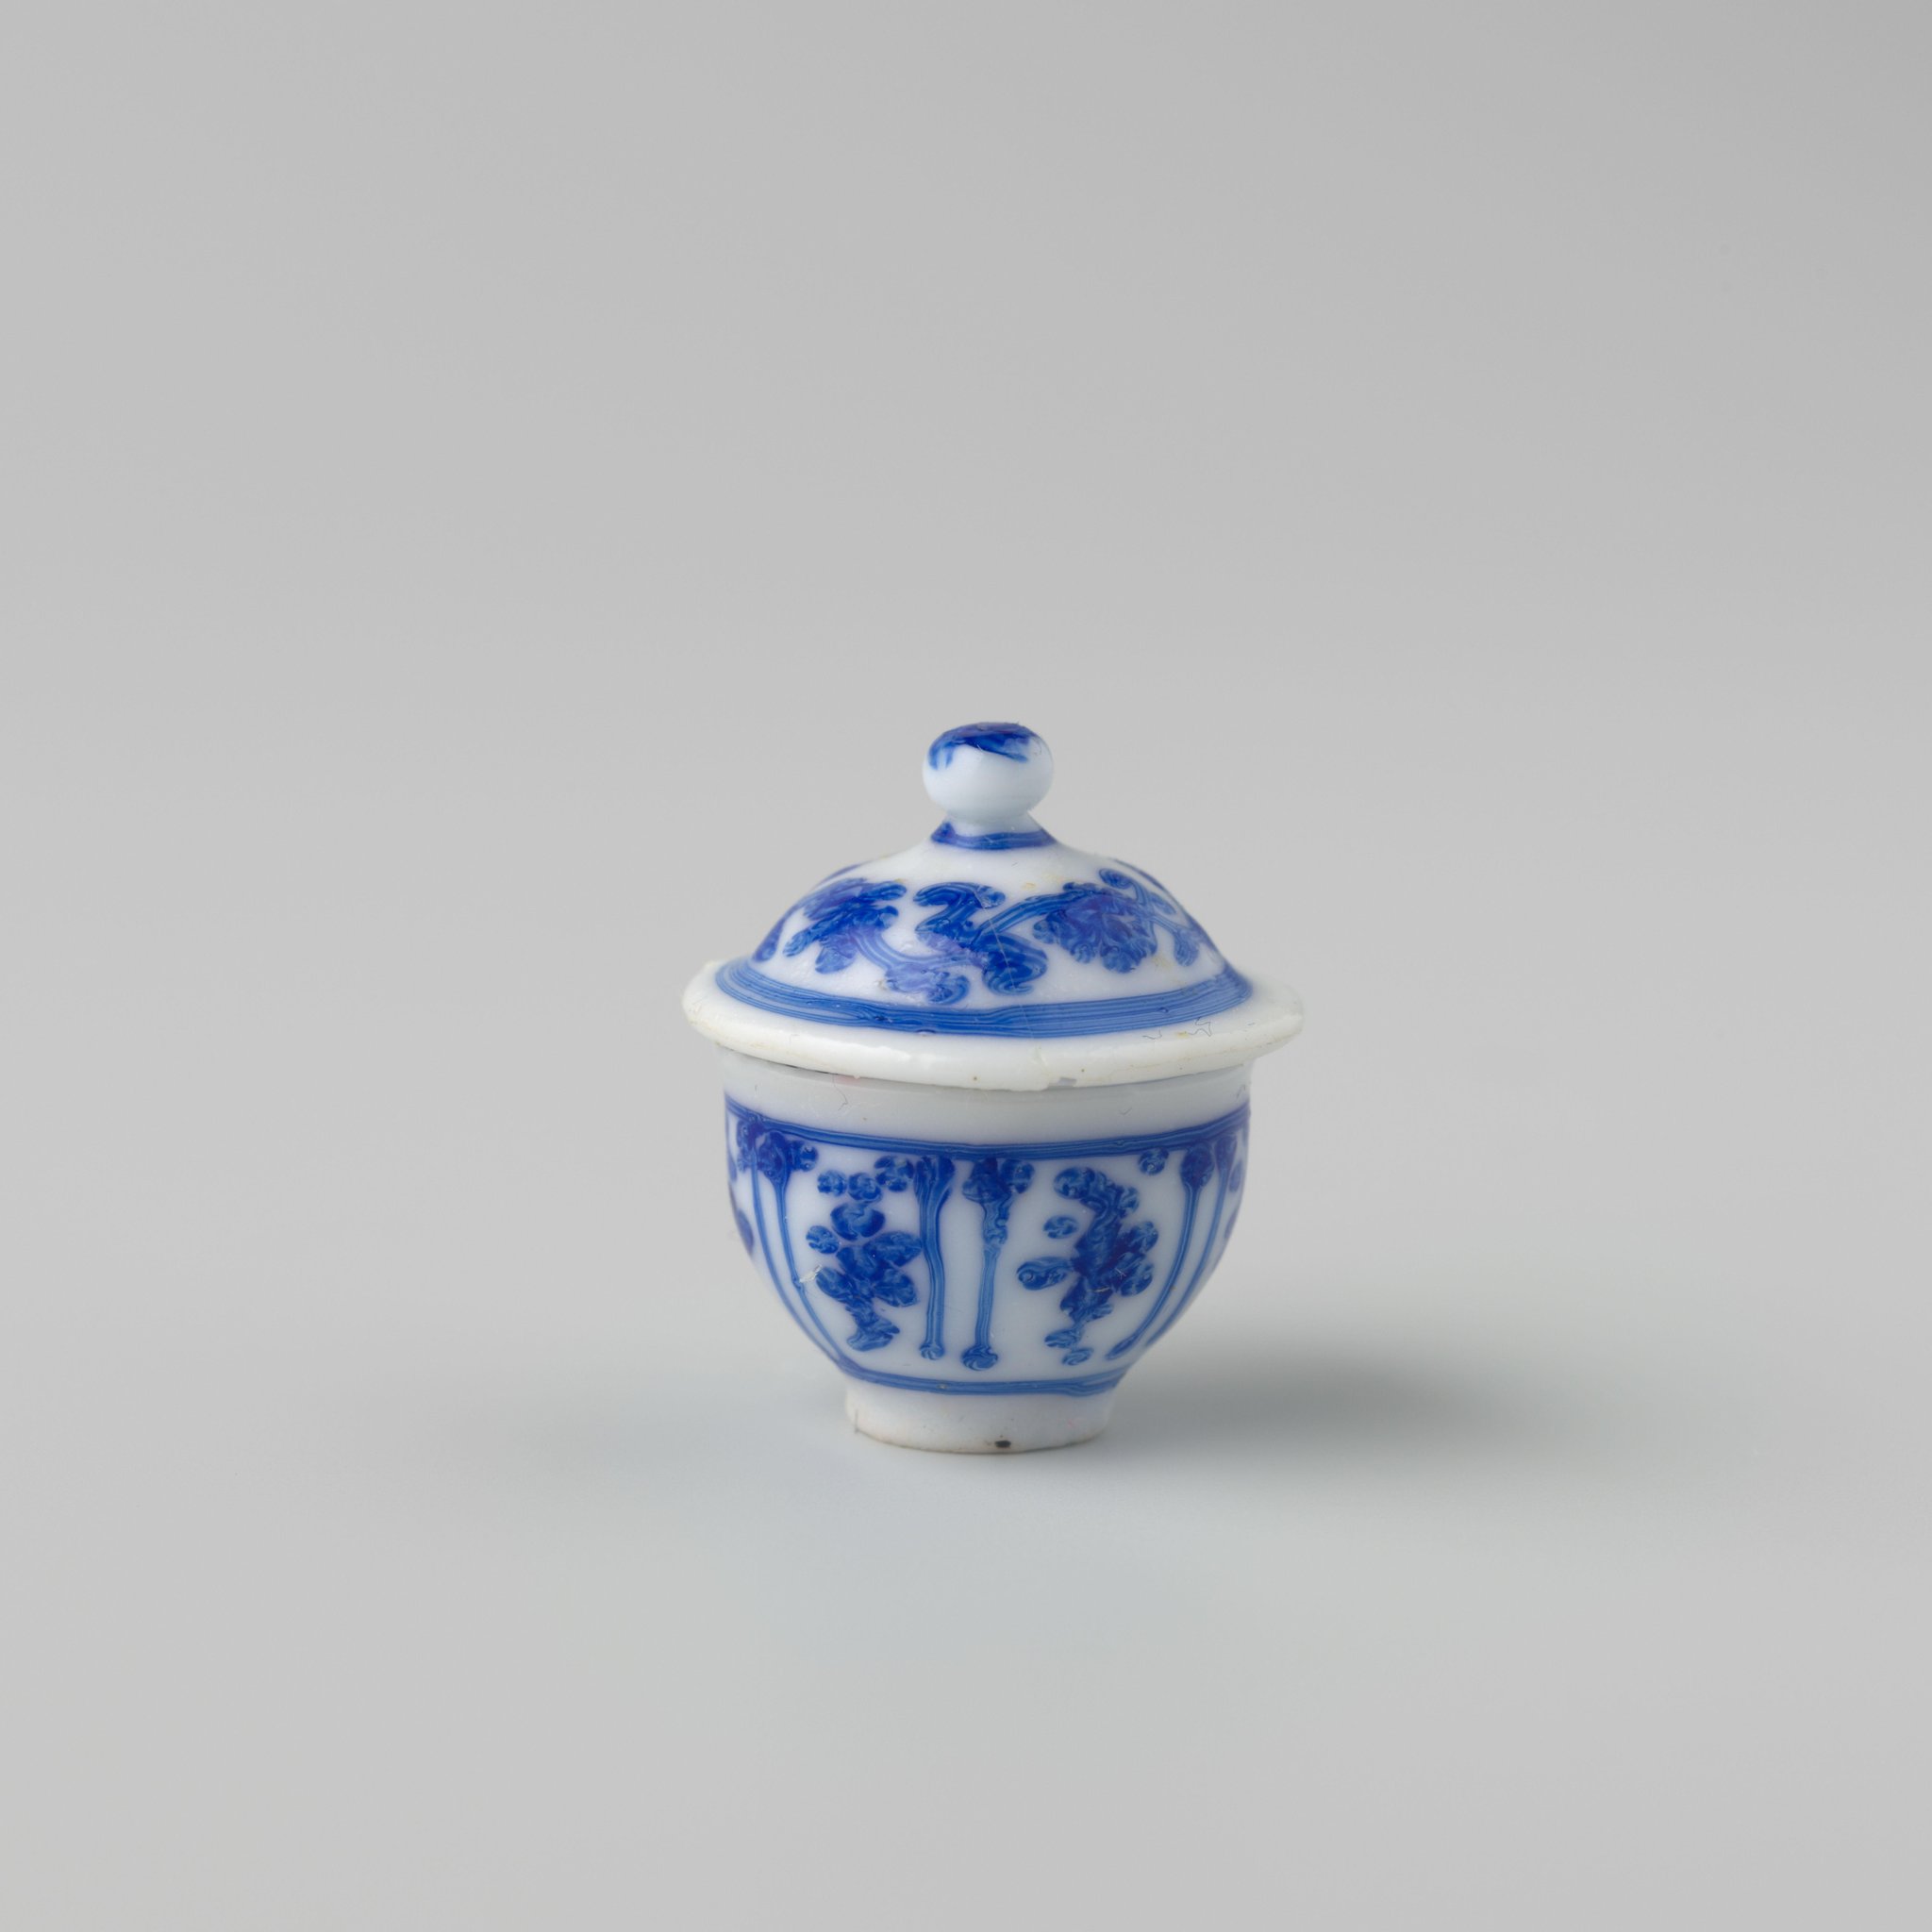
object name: miniature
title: Kom met deksel van melkglas met blauwe emailverf beschildering, imitatie Chinees porselein; kelkvormig kom met bloemmotieven tussen verticale lijnen, bolle deksel met knop.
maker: Anonymous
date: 1675-1710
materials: glass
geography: amsterdam